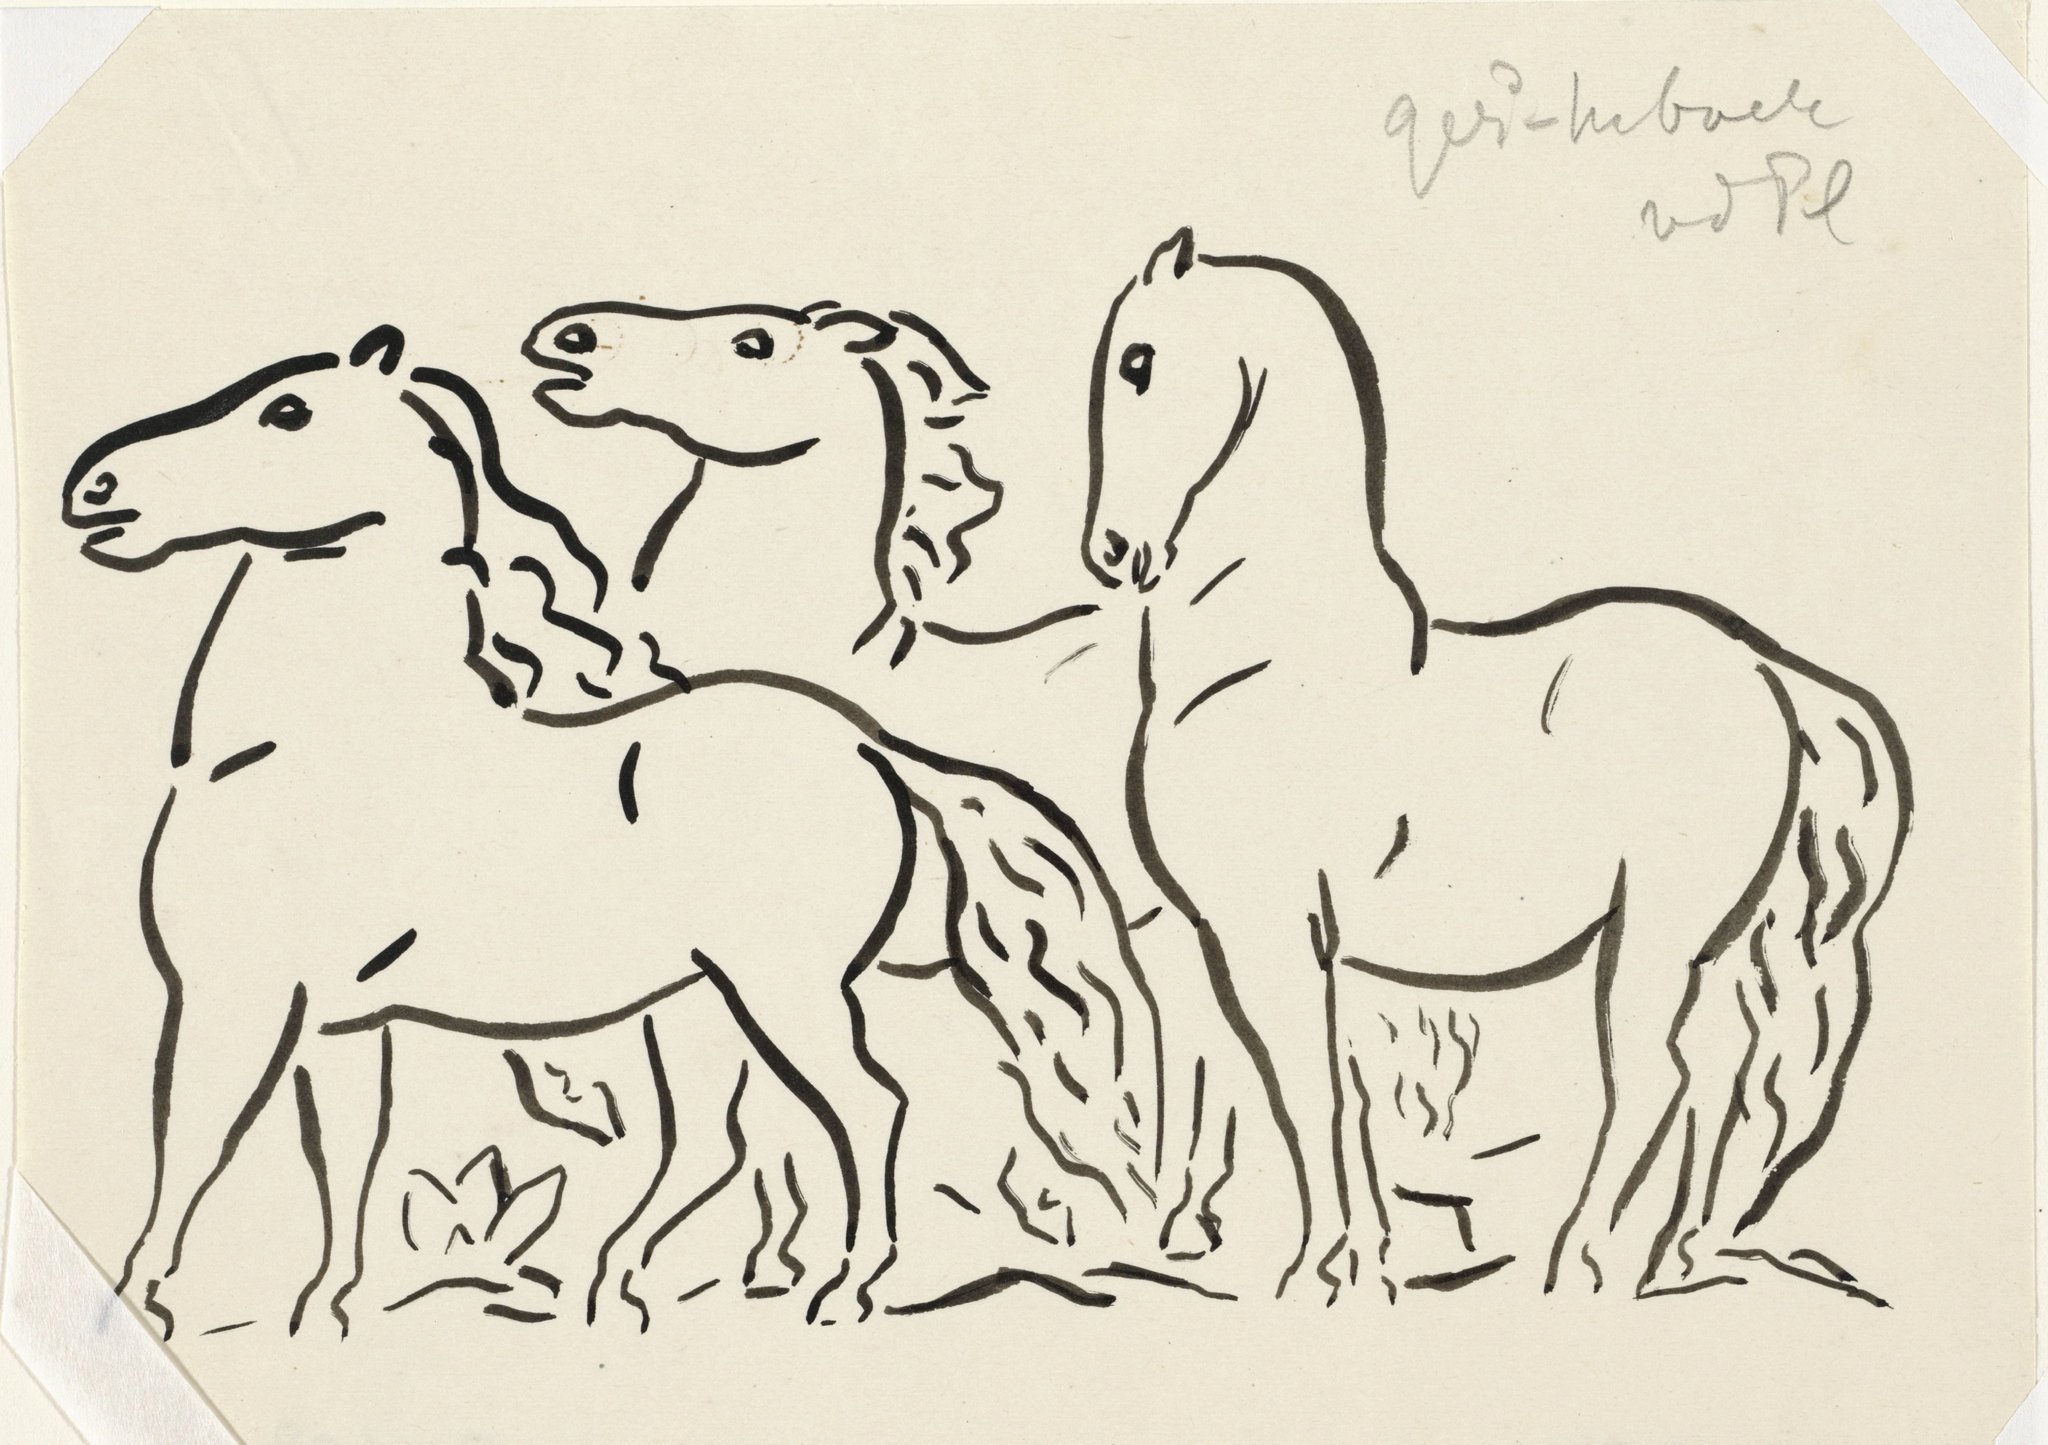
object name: drawing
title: Zonder titel Drie paarden, staand naar links kijkend, vignet voor biografie van Gestel door Prof. W. van der Pluym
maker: leo gestel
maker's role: draughtsman, print maker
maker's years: 1881-1941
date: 1935-1936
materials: ink, paper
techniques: brush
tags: horse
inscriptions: inscription: ‘ge.....boek / vd Pl’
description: Drie paarden staand naar links kijkend, de twee linker met opgeheven hoofd, de achterste met ingehouden hoofd